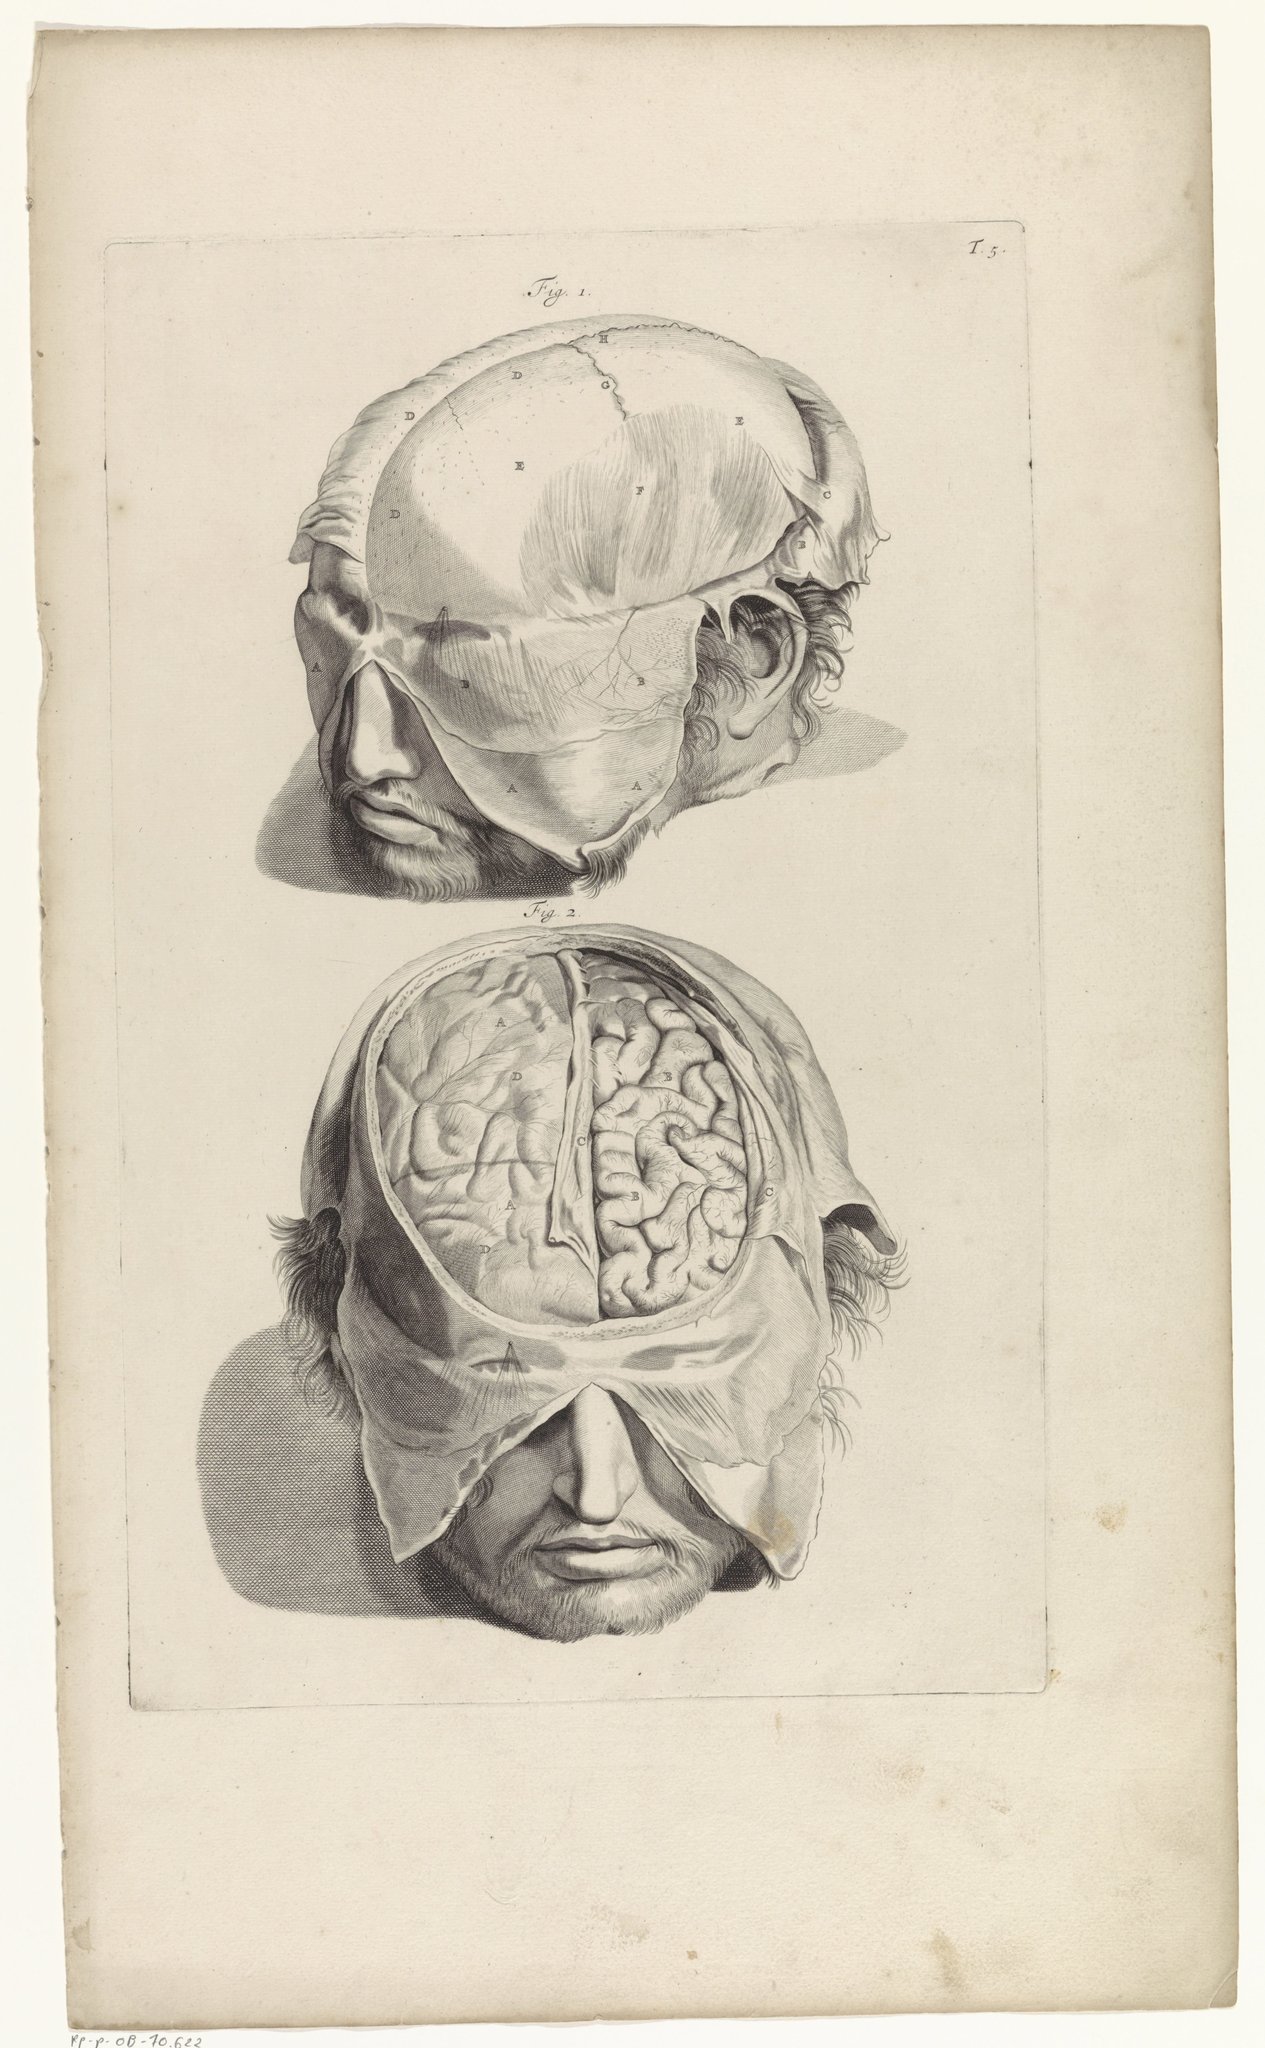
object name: print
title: Anatomische studie van het hoofd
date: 1685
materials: paper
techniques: engraving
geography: amsterdam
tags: brains, (human) skull (+ front view), (human) skull (+ seen from above)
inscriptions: collector's mark: Lugt 2228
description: Boekillustratie voor Bidloo, Godefridus. Anatomia humani corporis centum & quinque tabulis, per art. G. de Lairesse ad vivum delineatis, de monstrata, veterum recentiorumque inventis explicata plurimisque, hactenus non detectis, illustrata. Amsterdam: Weduwe Joannes van Someren, Hendrick Boom en erven Dirk Boom, 1685.